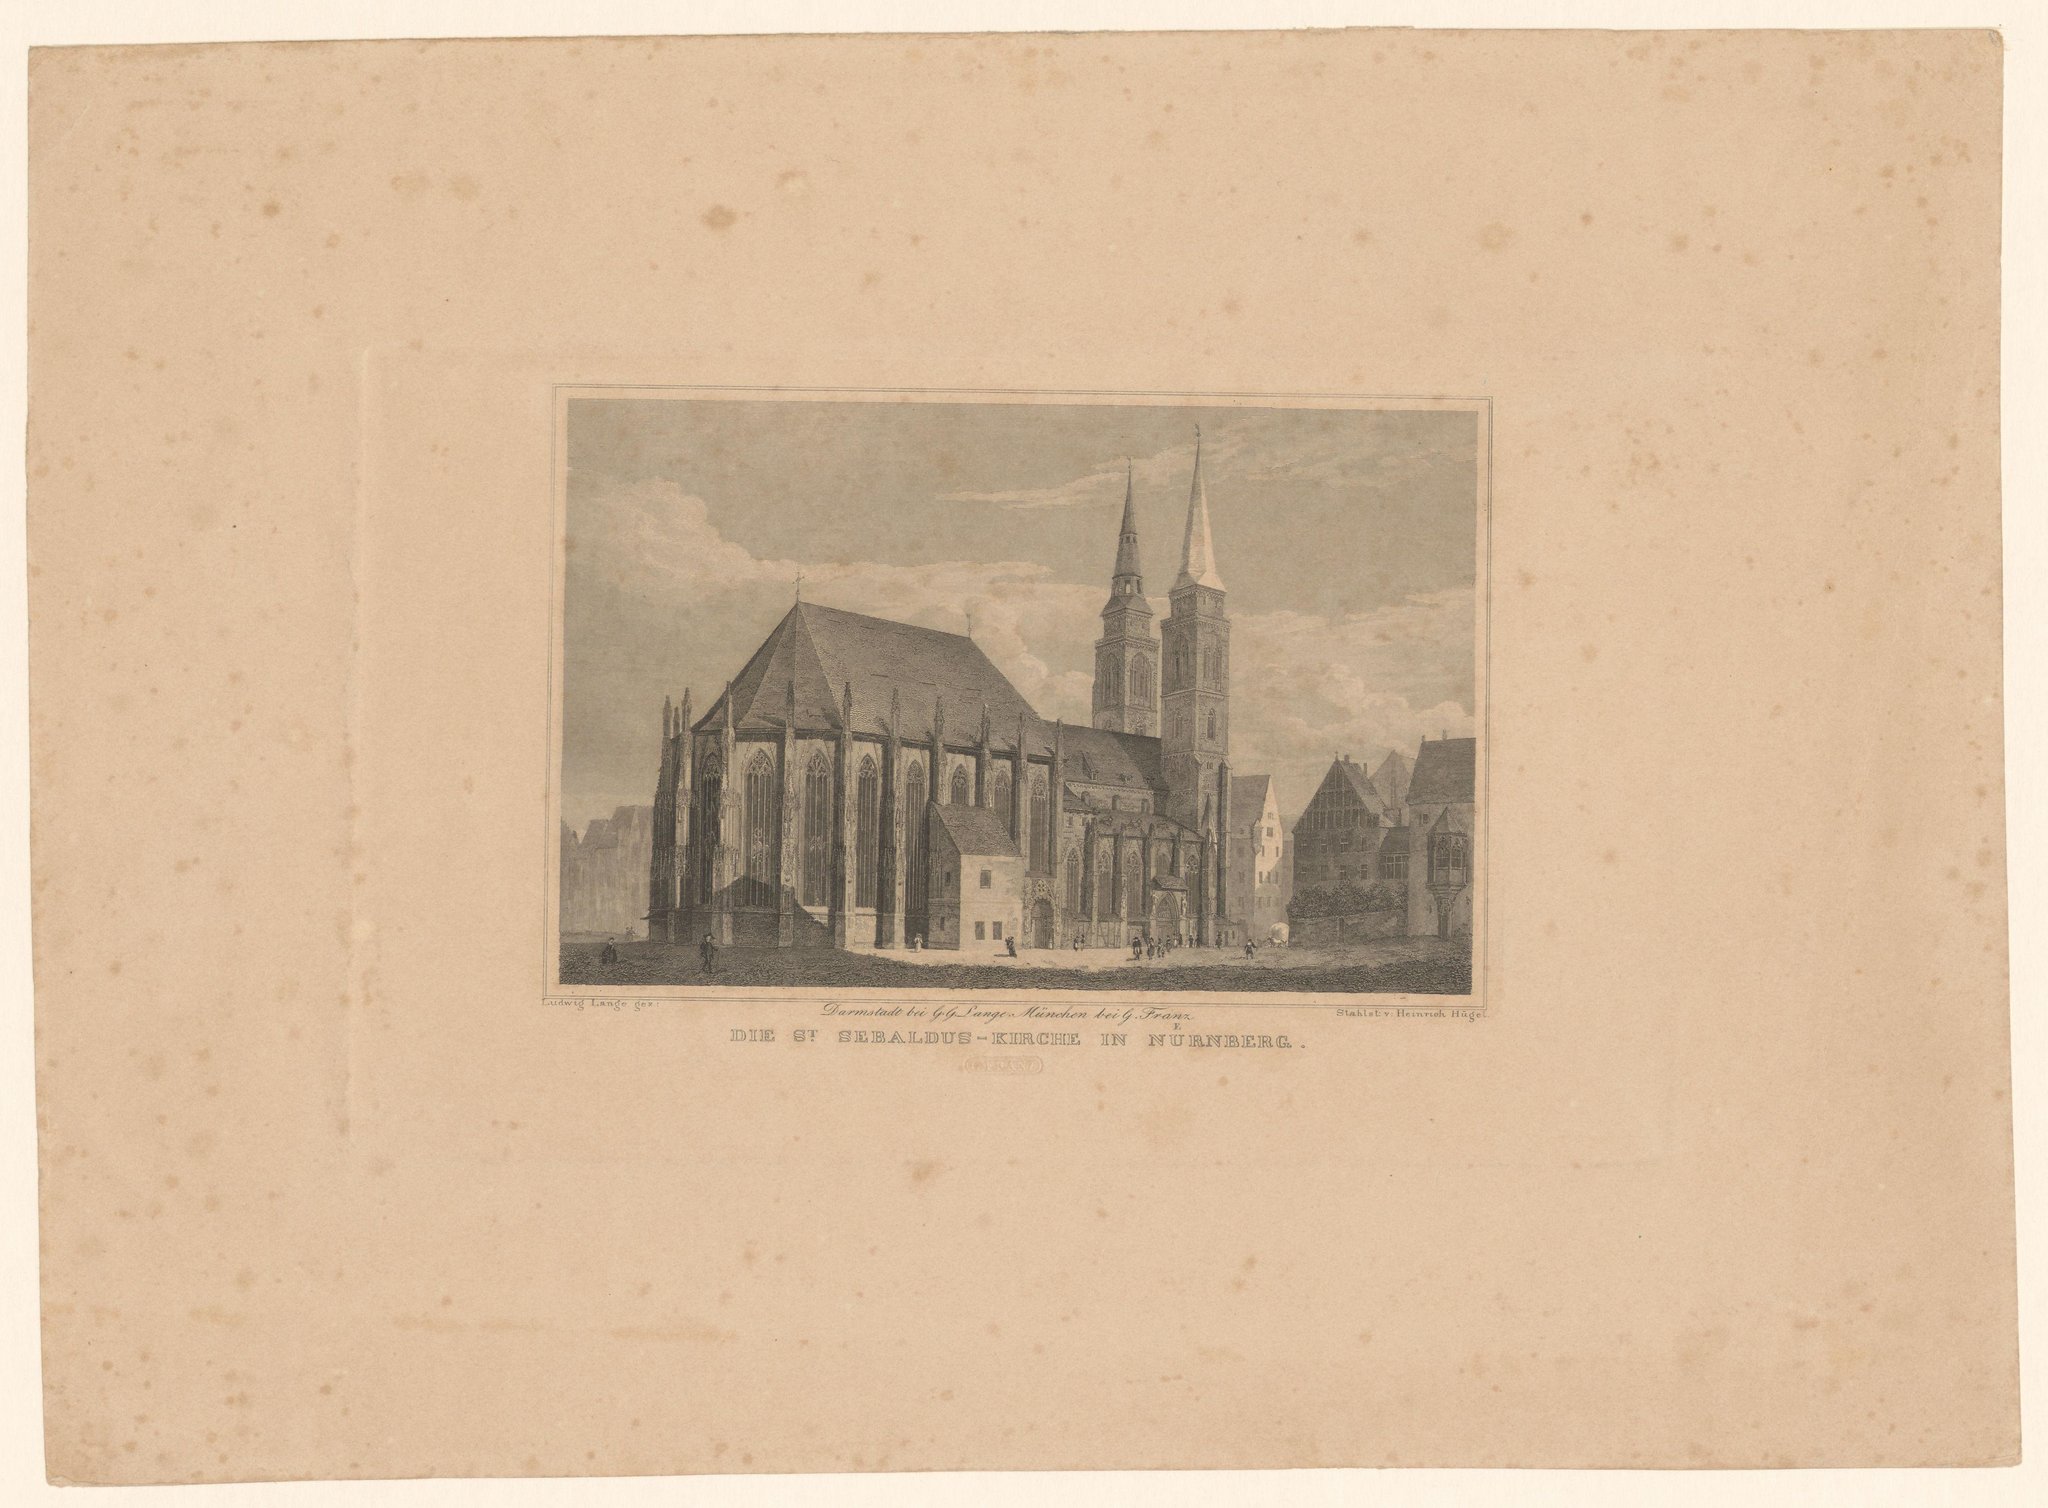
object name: print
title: Sint-Sebalduskerk te Neurenberg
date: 1839-1899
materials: paper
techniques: engraving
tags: church (exterior)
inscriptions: check stamp: ‘G.Franz’, collector's mark: Lugt 2228